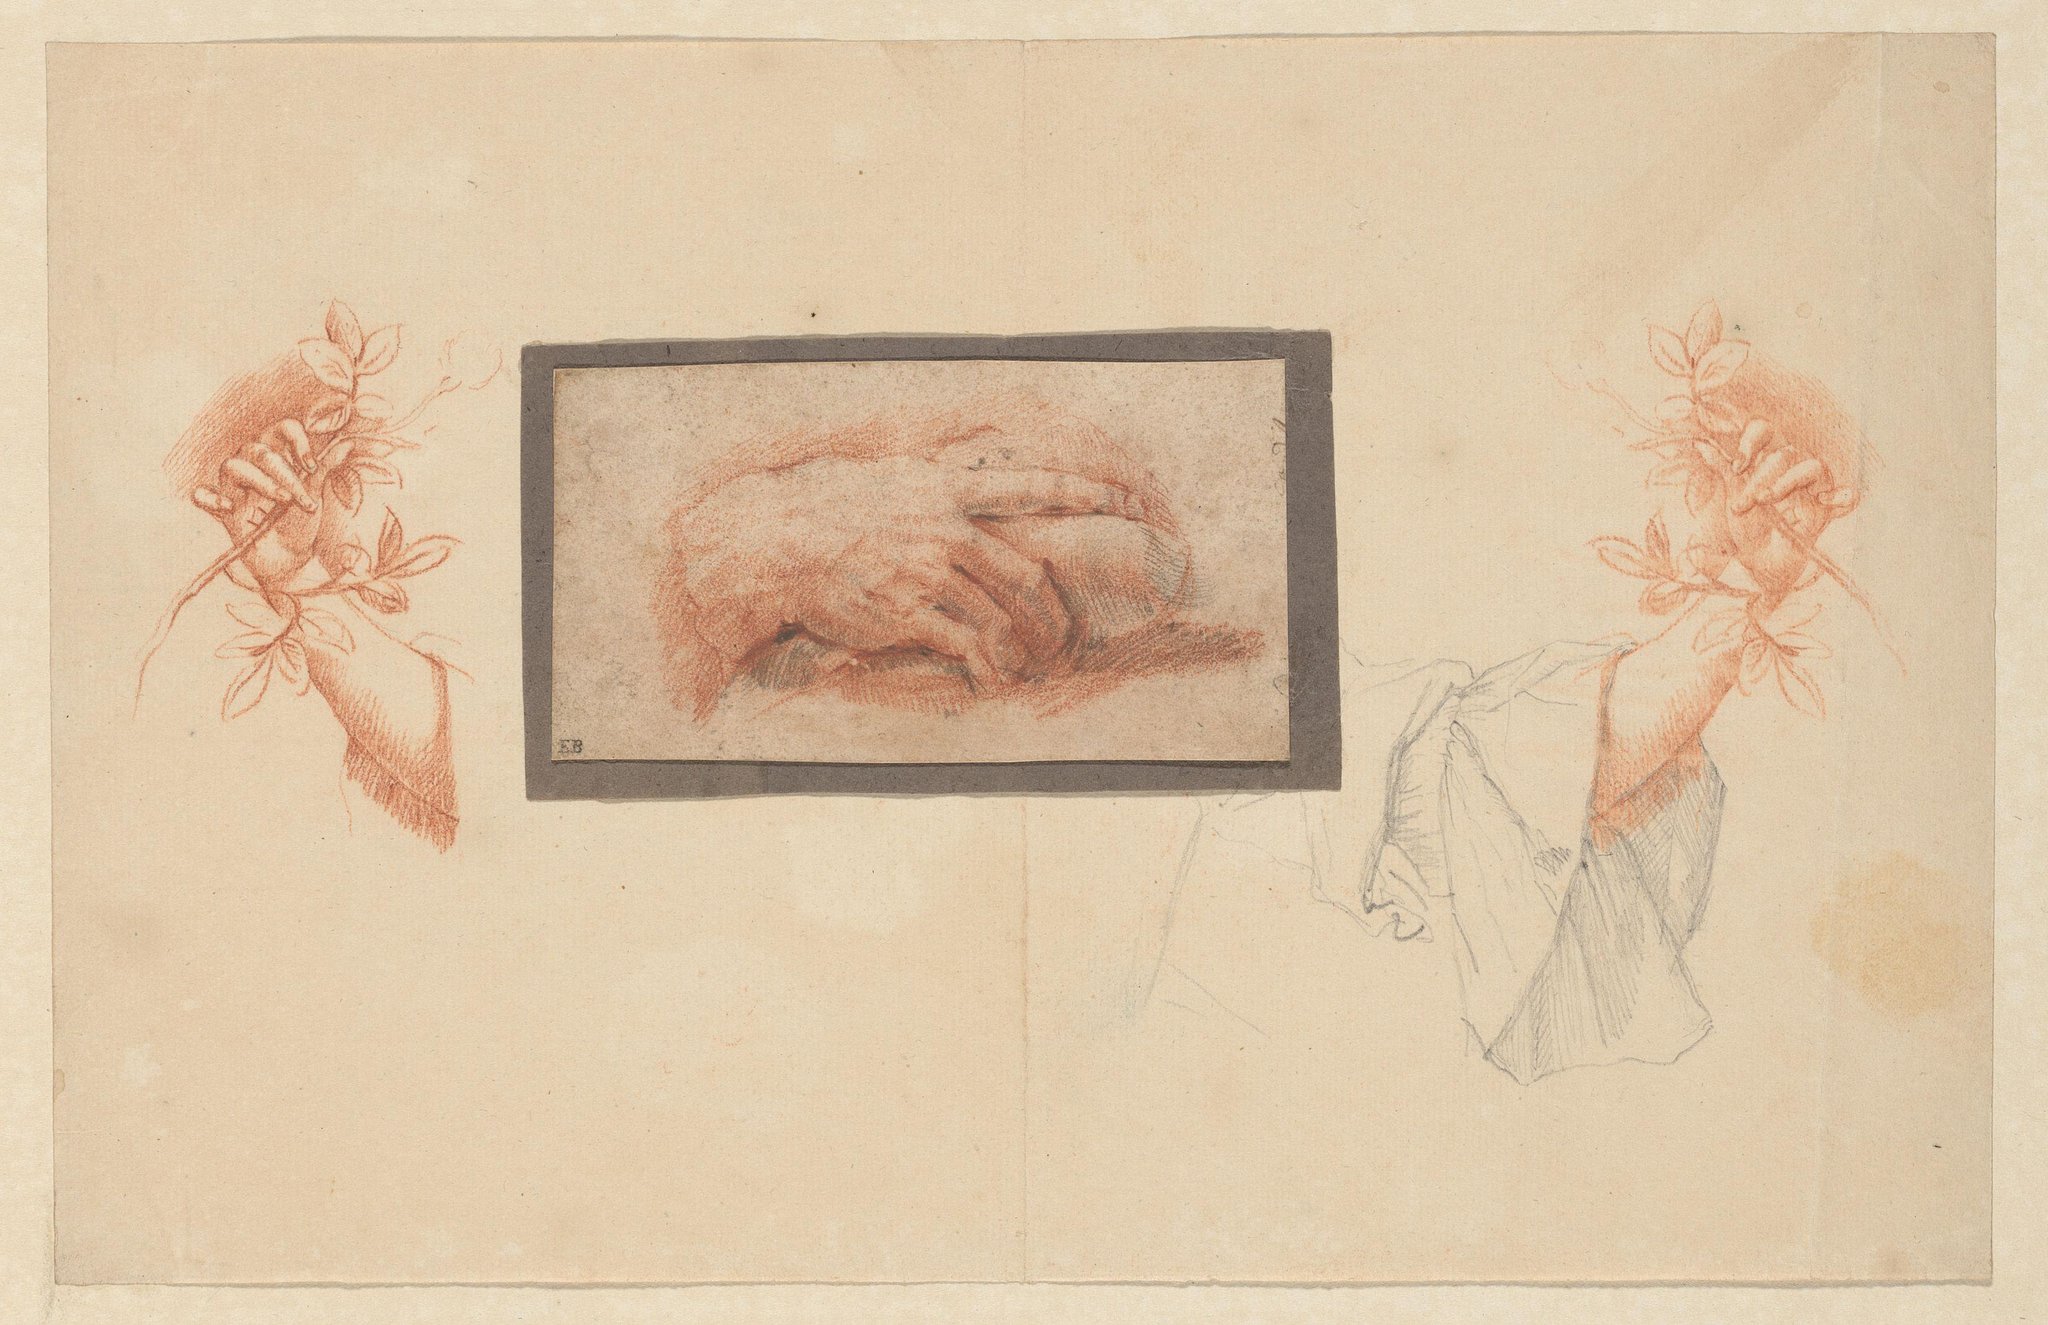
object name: drawing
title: Studie van een hand en twee handen met een tak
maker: Anonymous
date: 1649-1723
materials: chalk, paper, pencil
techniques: pasting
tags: postures and gestures of hand and fingers, trees (+ branch, stick)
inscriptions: collector's mark: ‘EB’